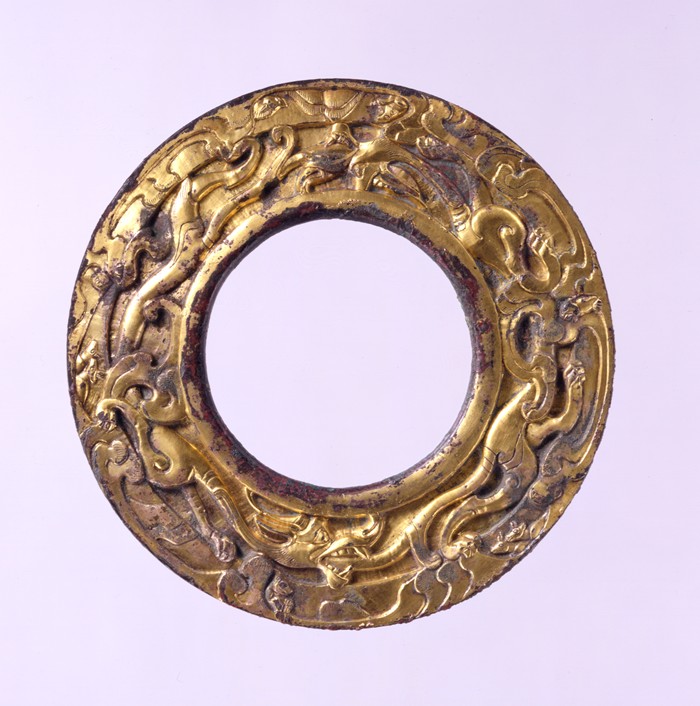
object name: bridle fitting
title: Bridle Fitting with Mythological Landscape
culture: north chinese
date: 300-101 BCE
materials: bronze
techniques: gilding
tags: mythical creatures